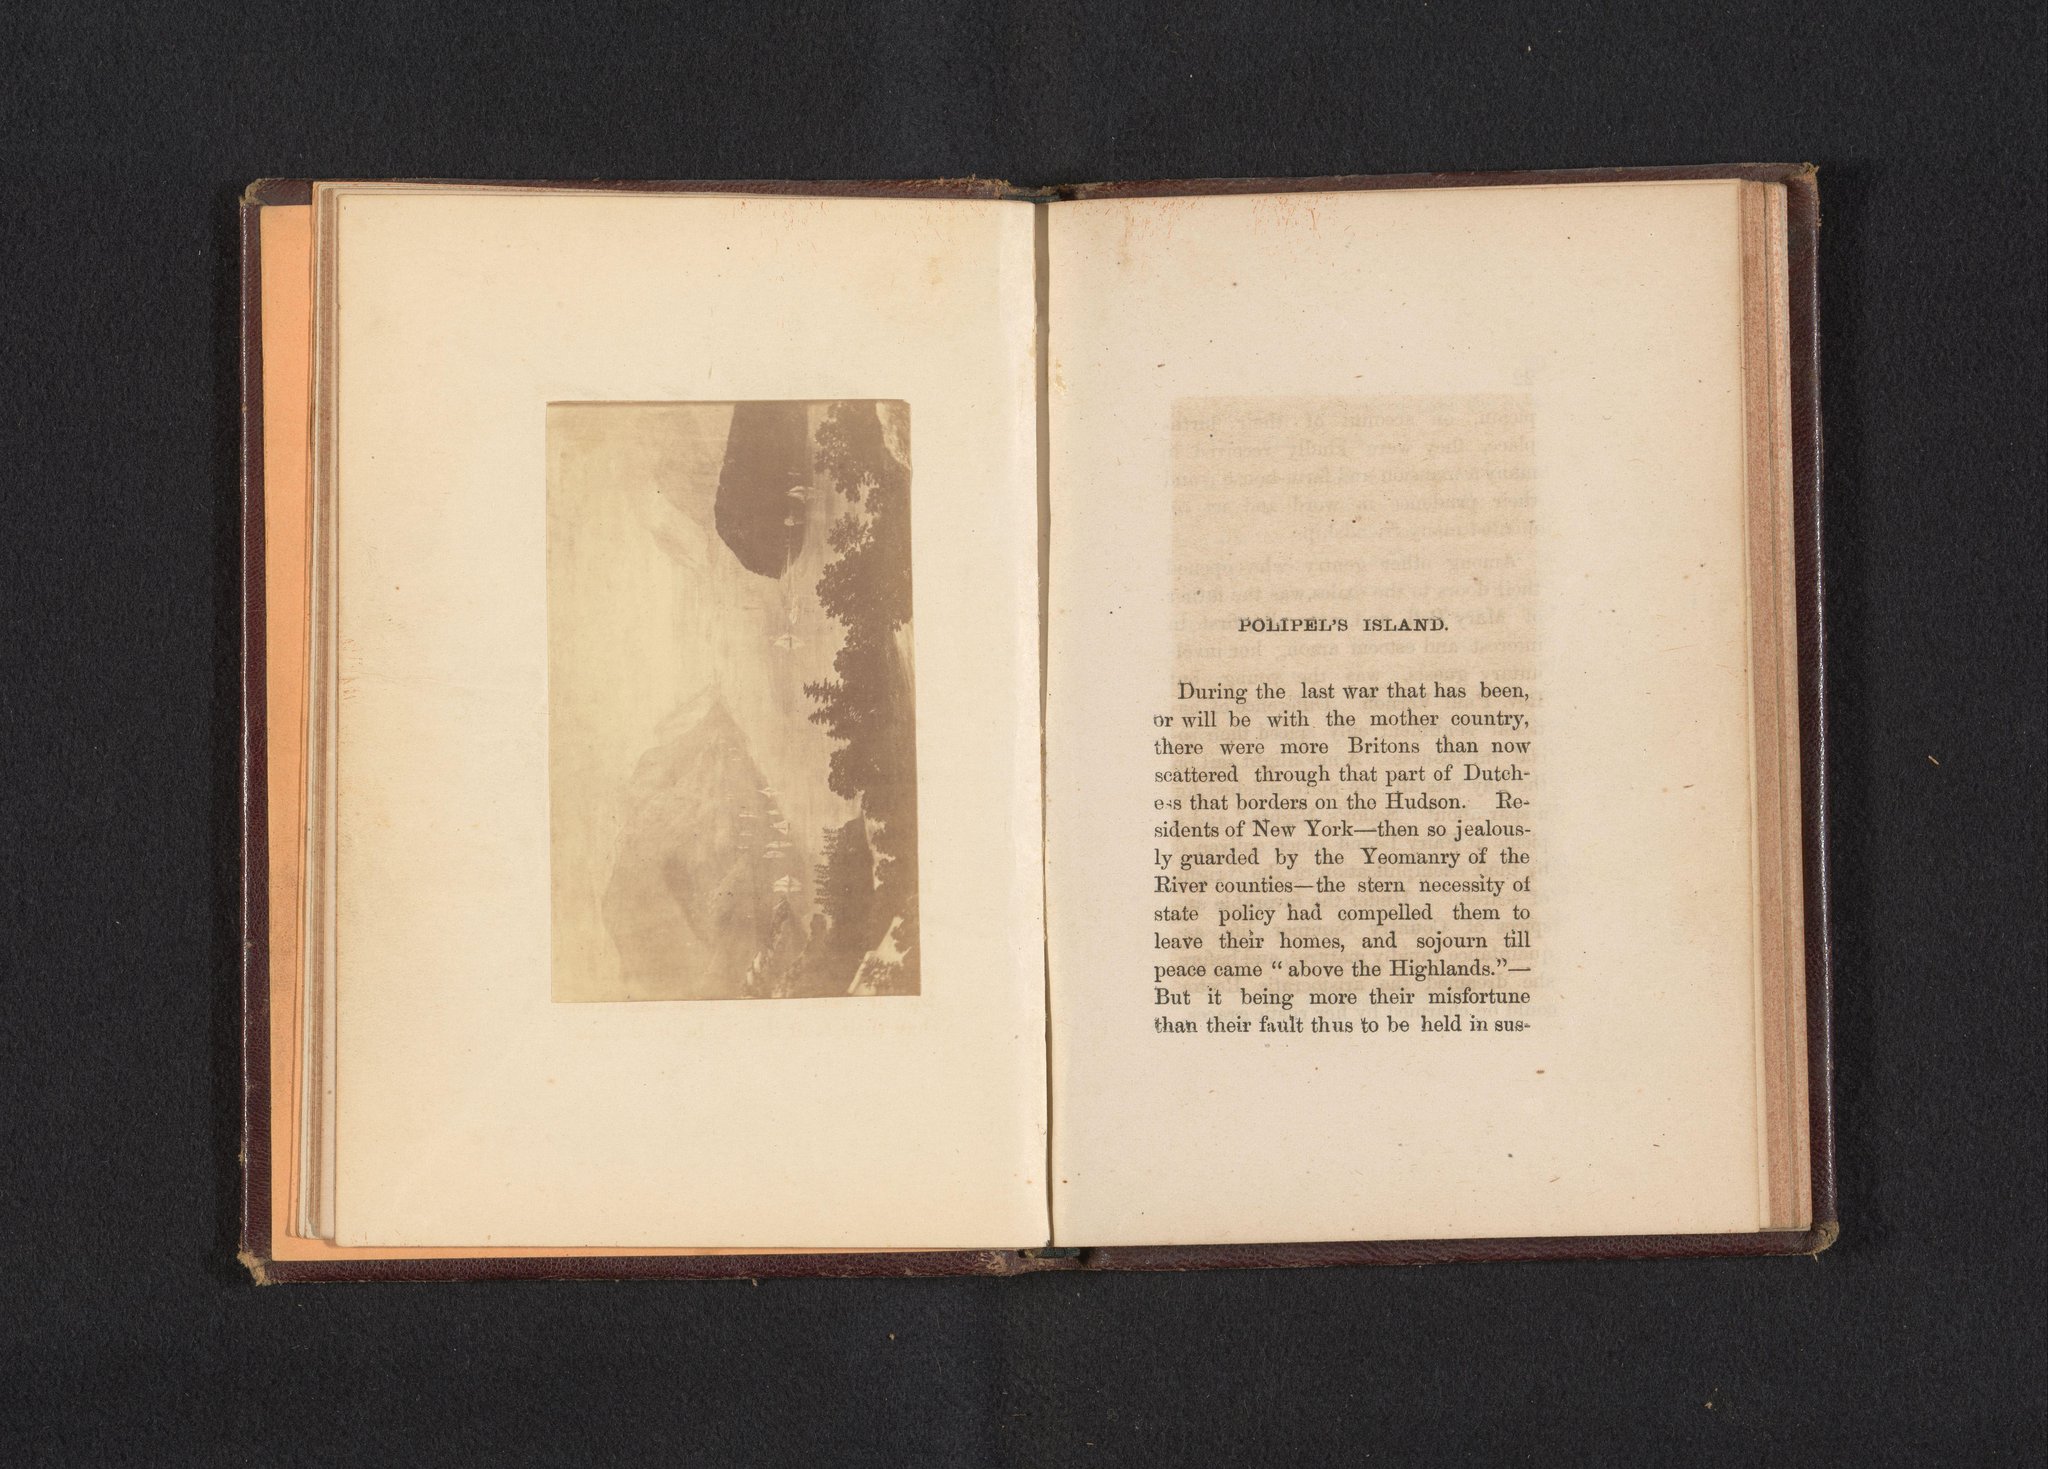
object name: page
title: Gezicht op boten in een baai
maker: Anonymous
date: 1863-1868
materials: photographic support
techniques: albumen print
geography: new york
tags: gulf, bay, sailing-ship, sailing-boat